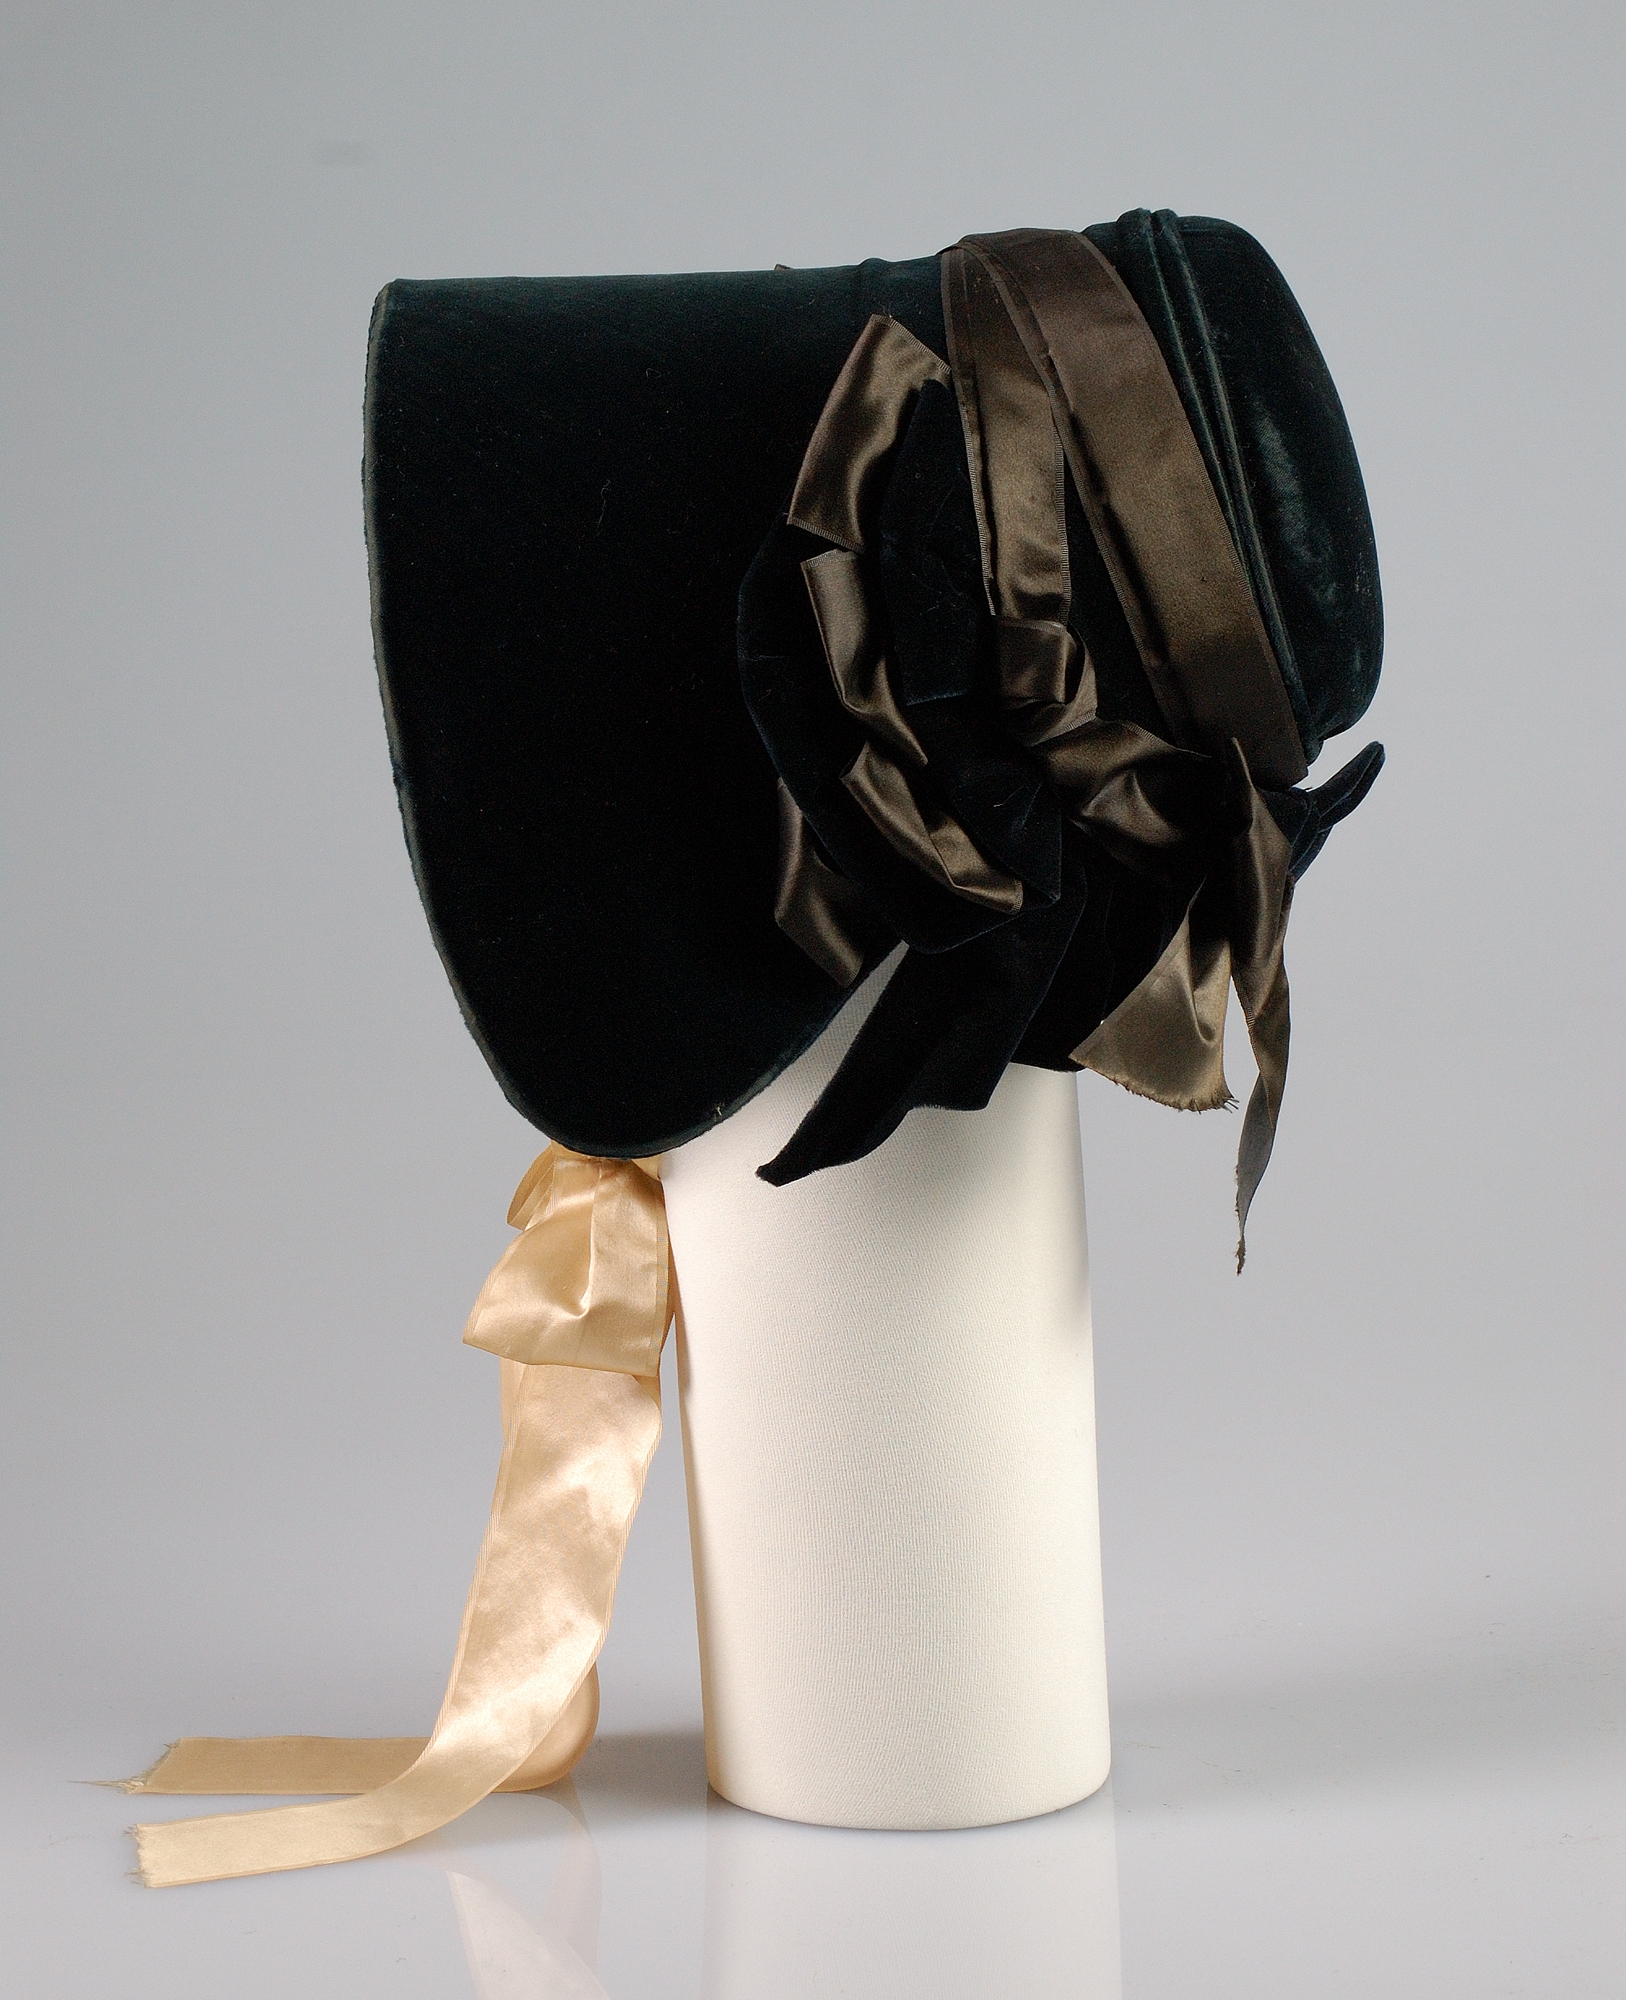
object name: poke bonnet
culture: american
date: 1848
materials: silk